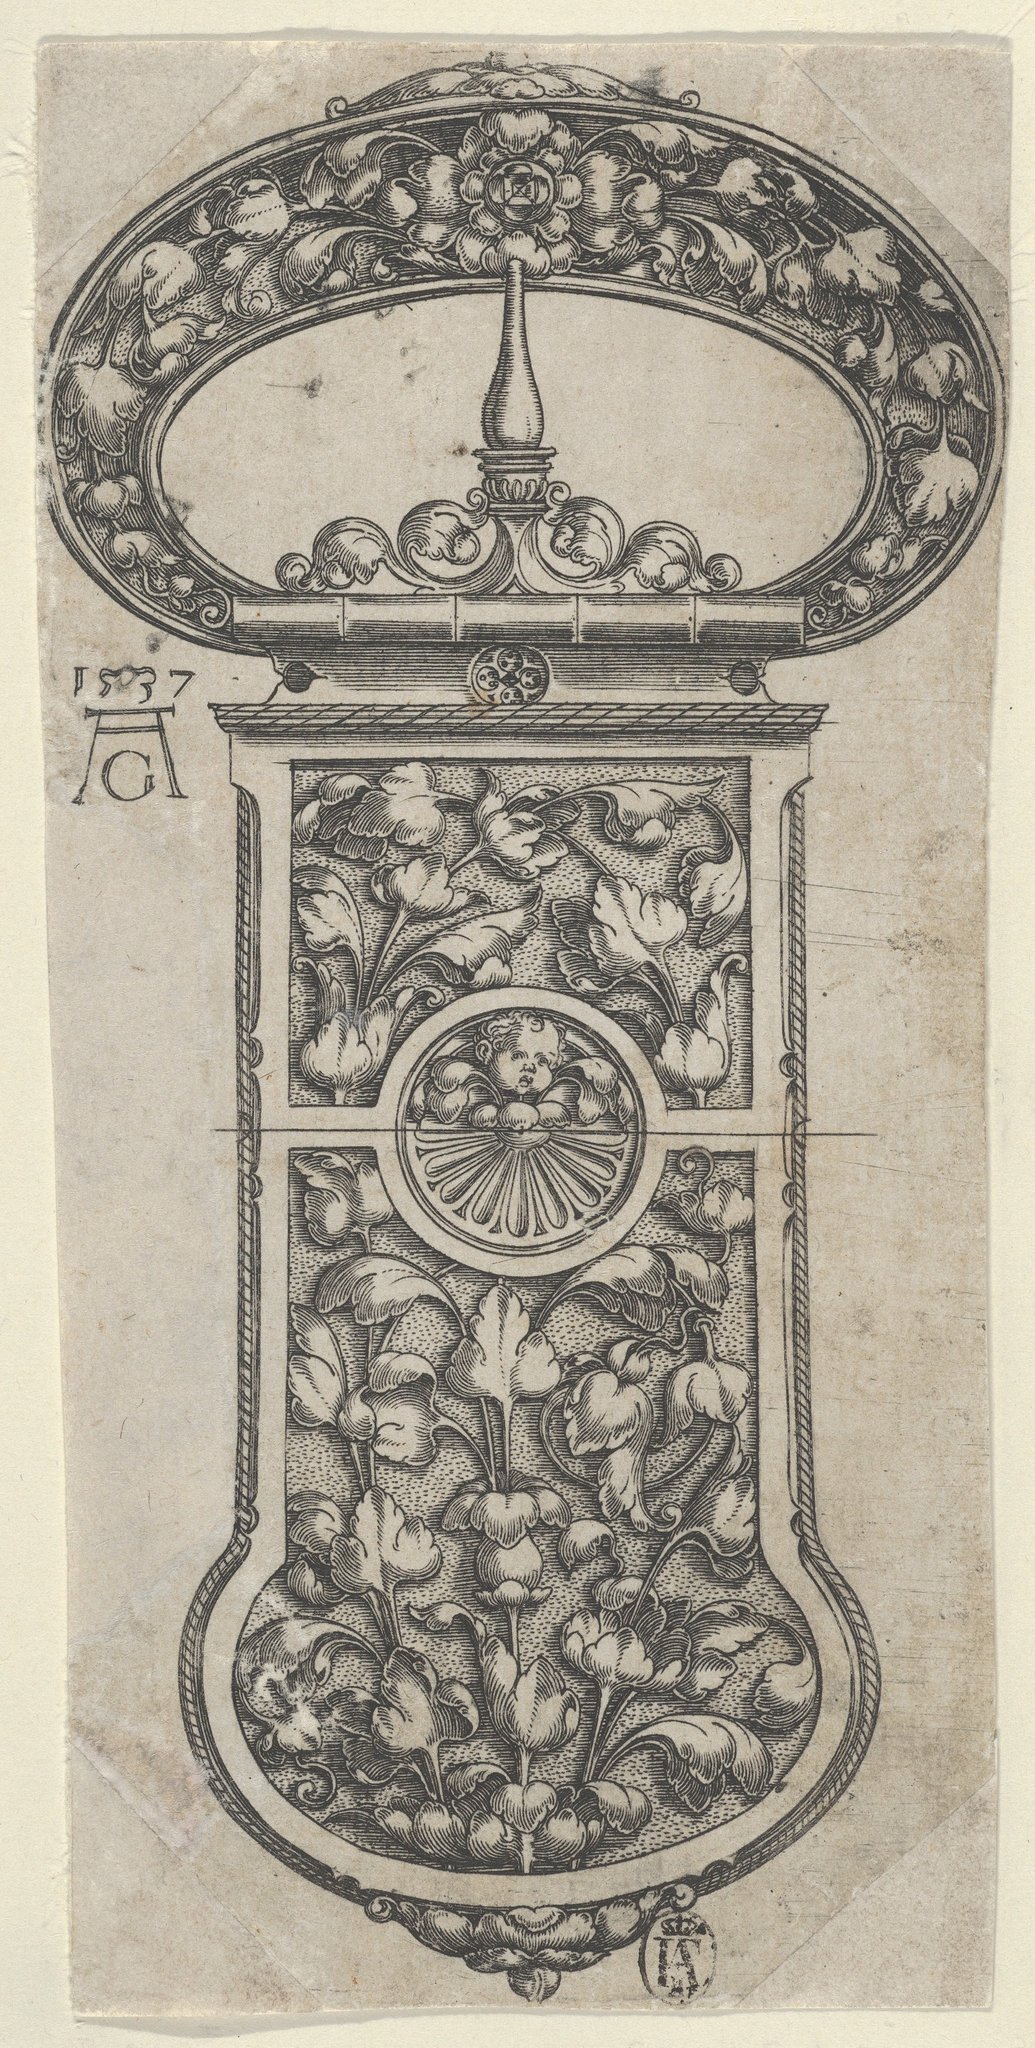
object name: print ornament architecture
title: Design for a Buckle with Tendrils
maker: heinrich aldegrever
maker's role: artist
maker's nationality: german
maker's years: 1502-1561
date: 1537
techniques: engraving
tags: buckles,ornament